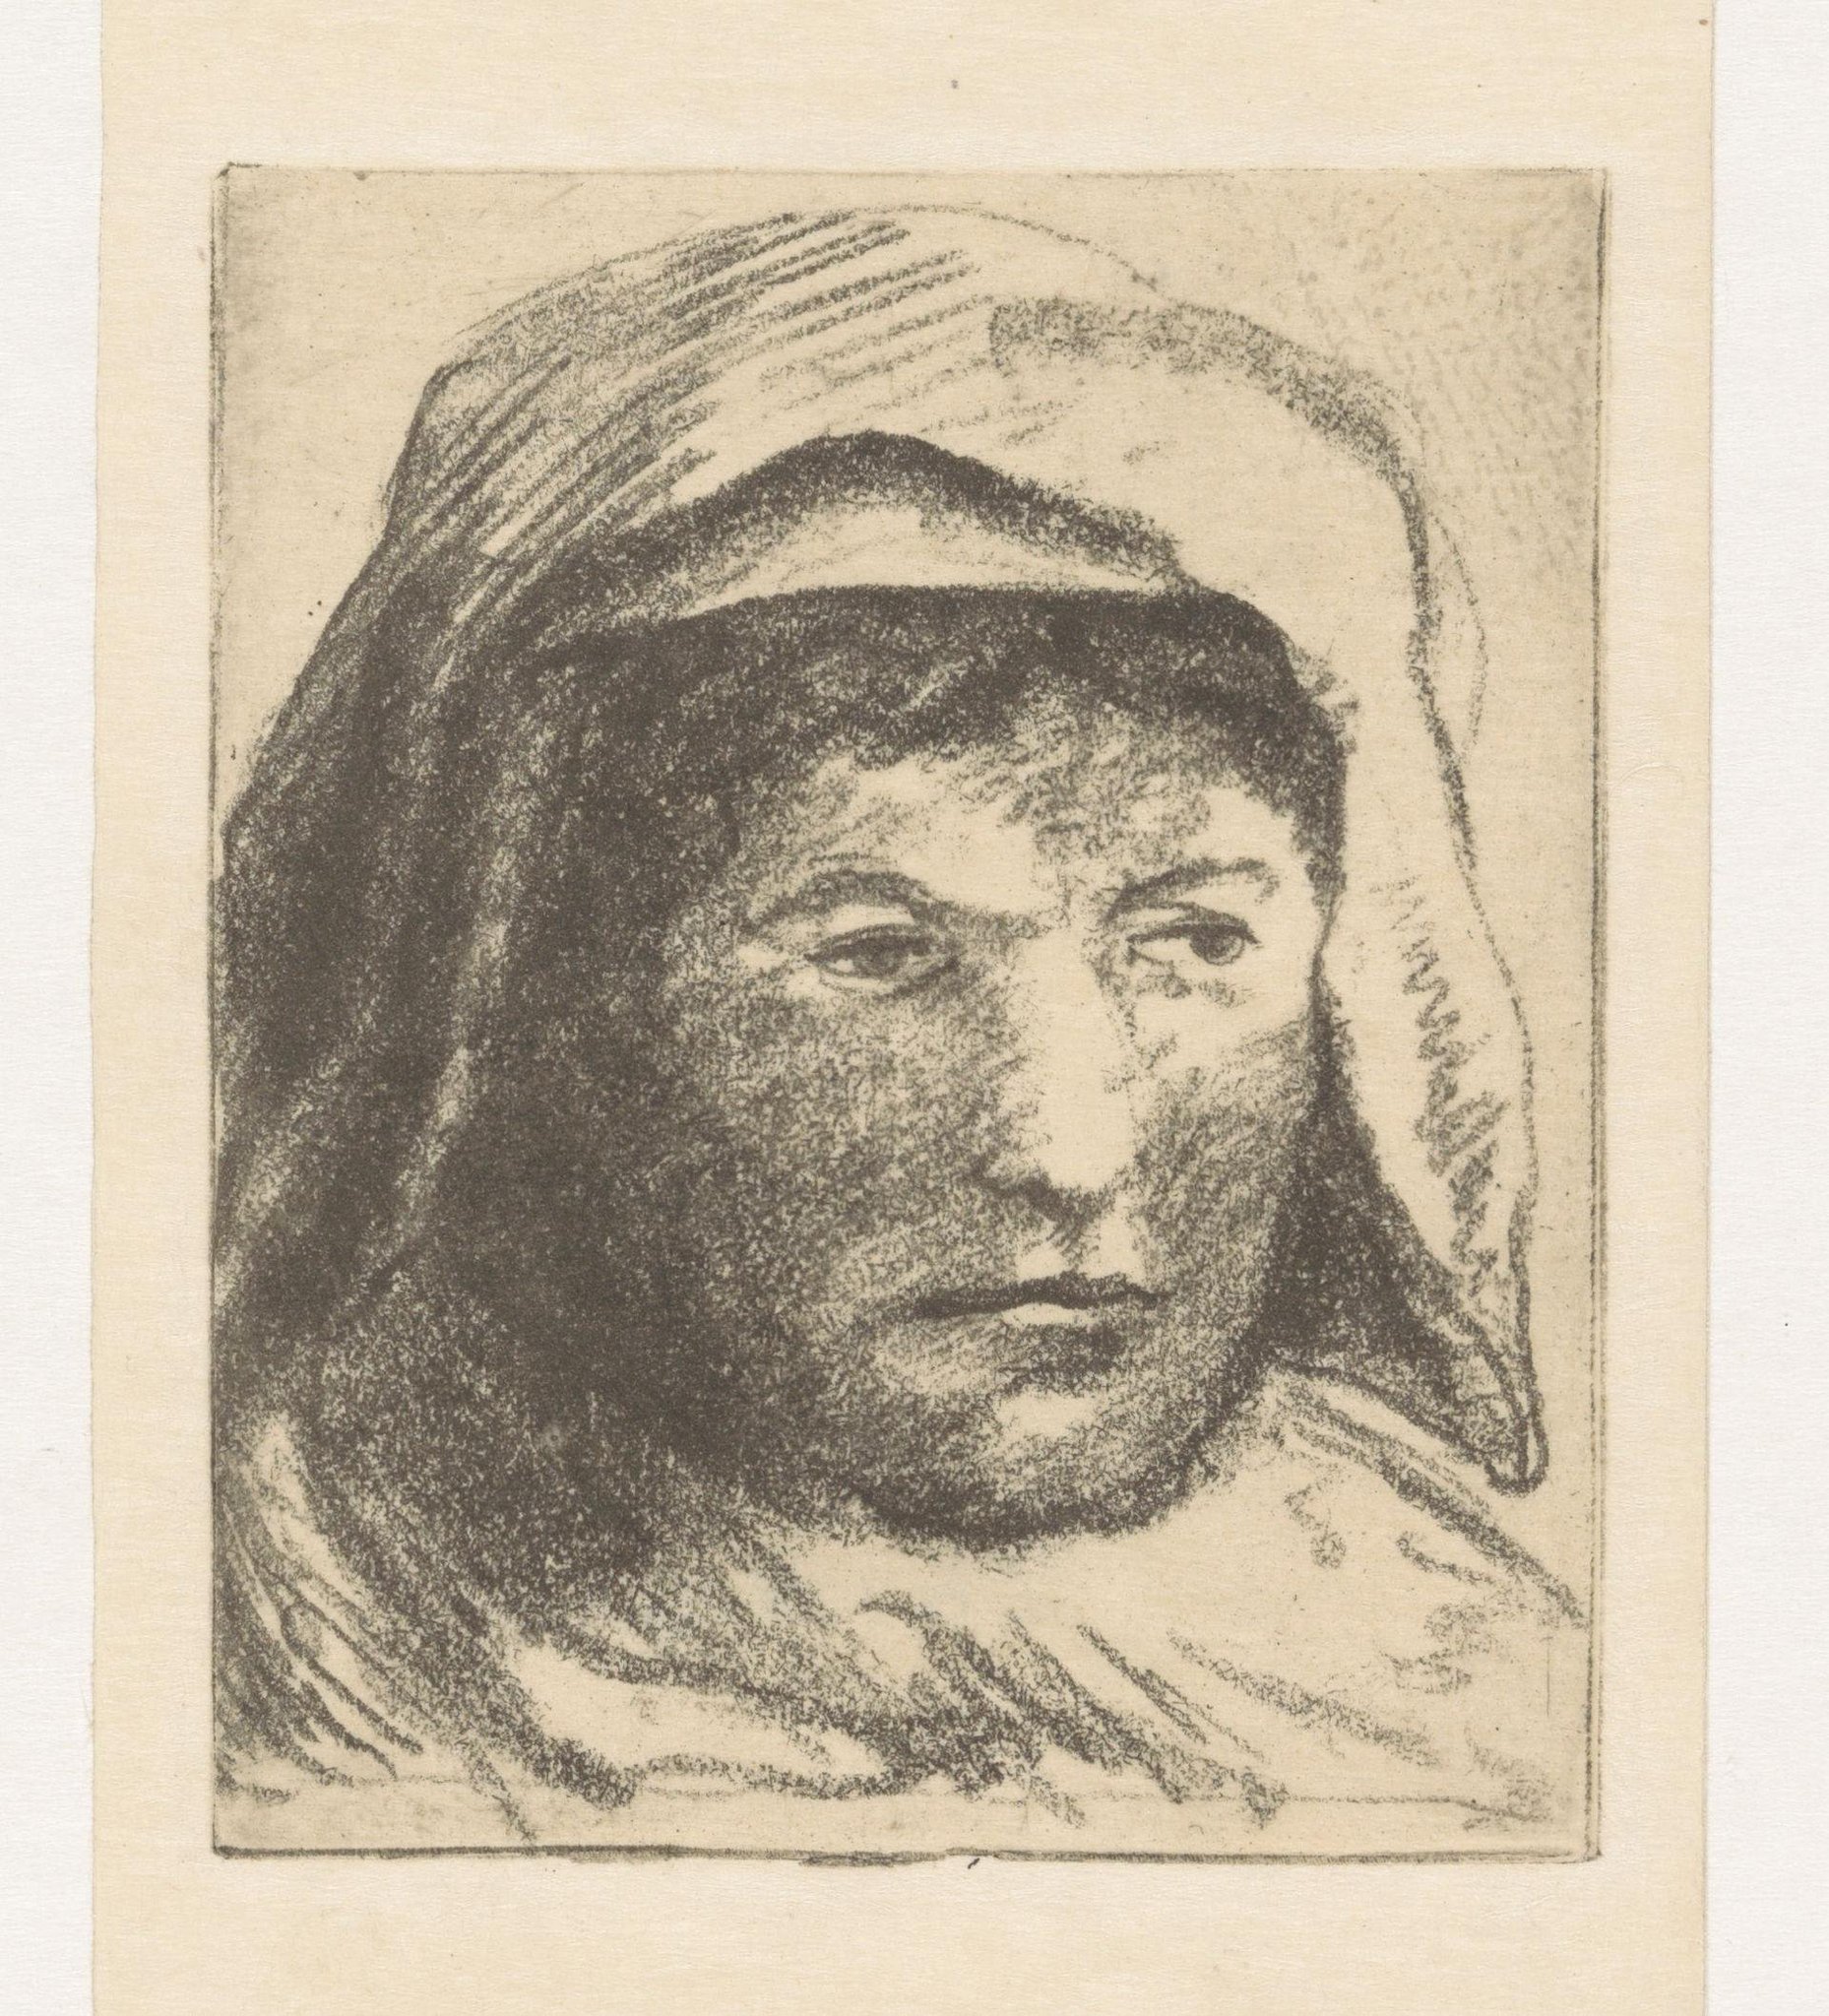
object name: print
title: Vrouw met hoofddoek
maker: marius holleman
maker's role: draughtsman, print maker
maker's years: 1878-1926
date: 1904-1926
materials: paper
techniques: etching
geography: groningen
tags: head-gear (with name)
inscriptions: collector's mark: Lugt 2228